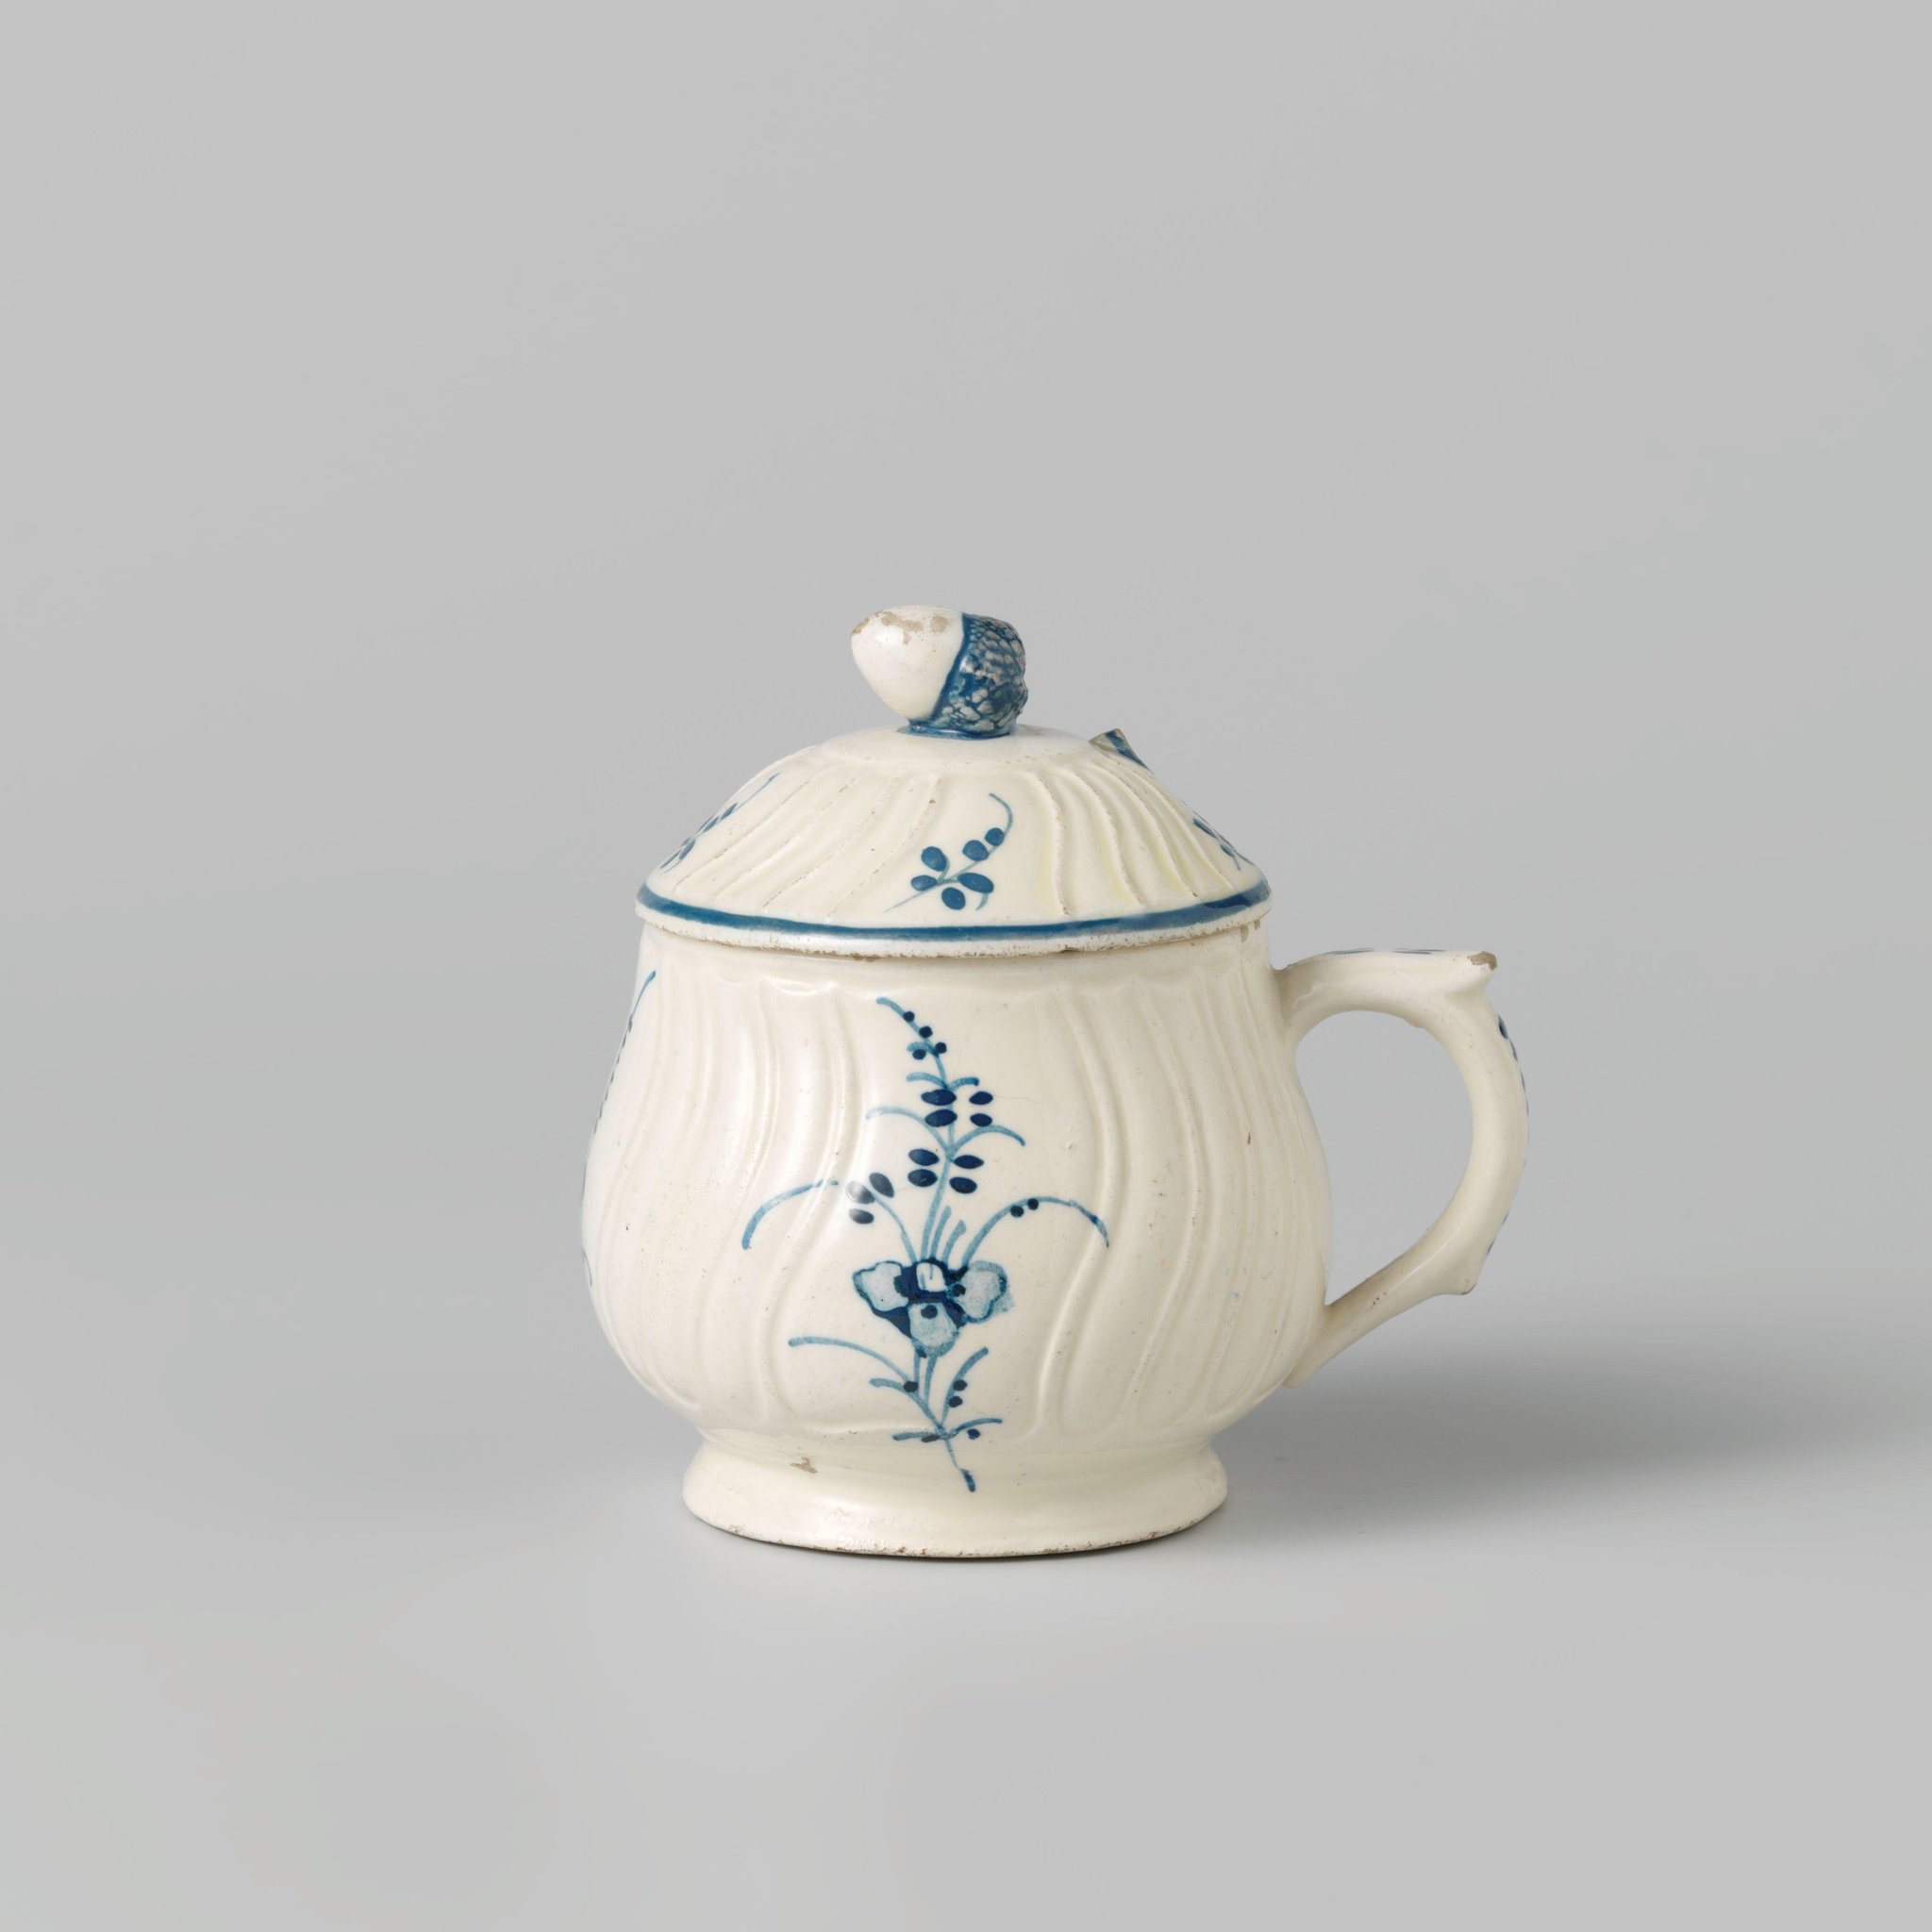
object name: lid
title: Deksel van hardgebakken aardewerk: Boch faience fine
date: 1775-1810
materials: earthenware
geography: luxembourg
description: Een gewelfd deksel met een knop in de vorm van een eikel. Het deksel heeft eveneens lijnornamenten met blauw gecshilderde bloemtakken. De eikel is voor de helft blauw gekleurd.